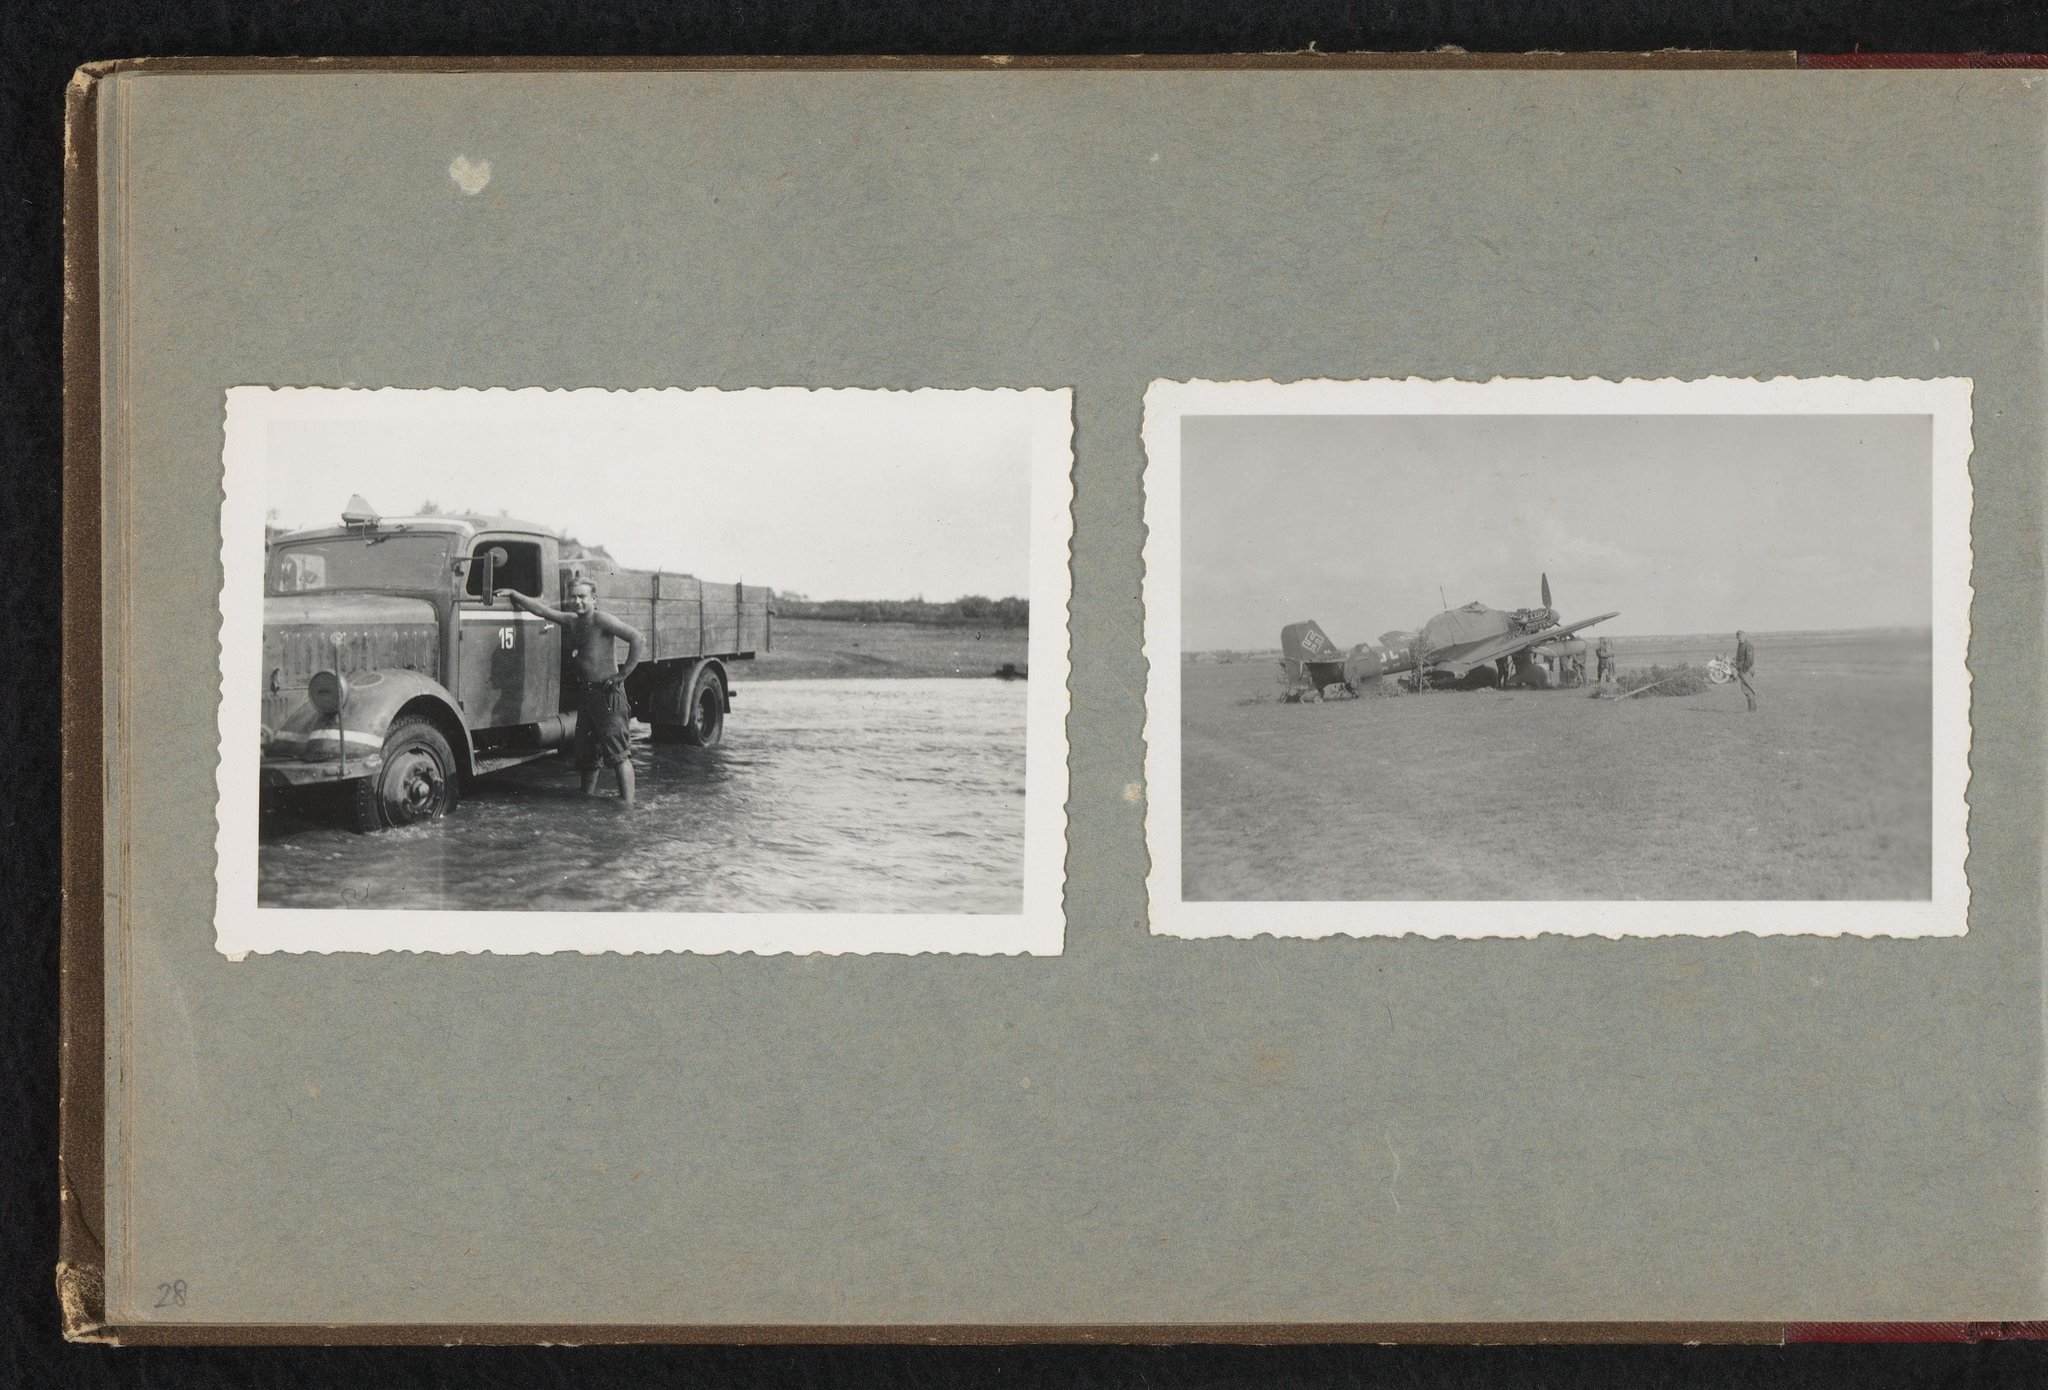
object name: photograph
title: Vrachtauto en vliegtuig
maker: Anonymous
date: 1940-1945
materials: paper, photographic support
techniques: gelatin silver print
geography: germany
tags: truck, van, aircraft, aeroplane, modern forms of military vehicles, germany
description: Albumblad met twee foto's van Duitse militairen bij een vrachtauto en bij het wrak van een neergestorte Duitse jager. Onderdeel van een fotoalbum over de diensttijd van Dieter Glitsch uit Hardegsen tijdens de Tweede Wereldoorlog en de jaren daarna.